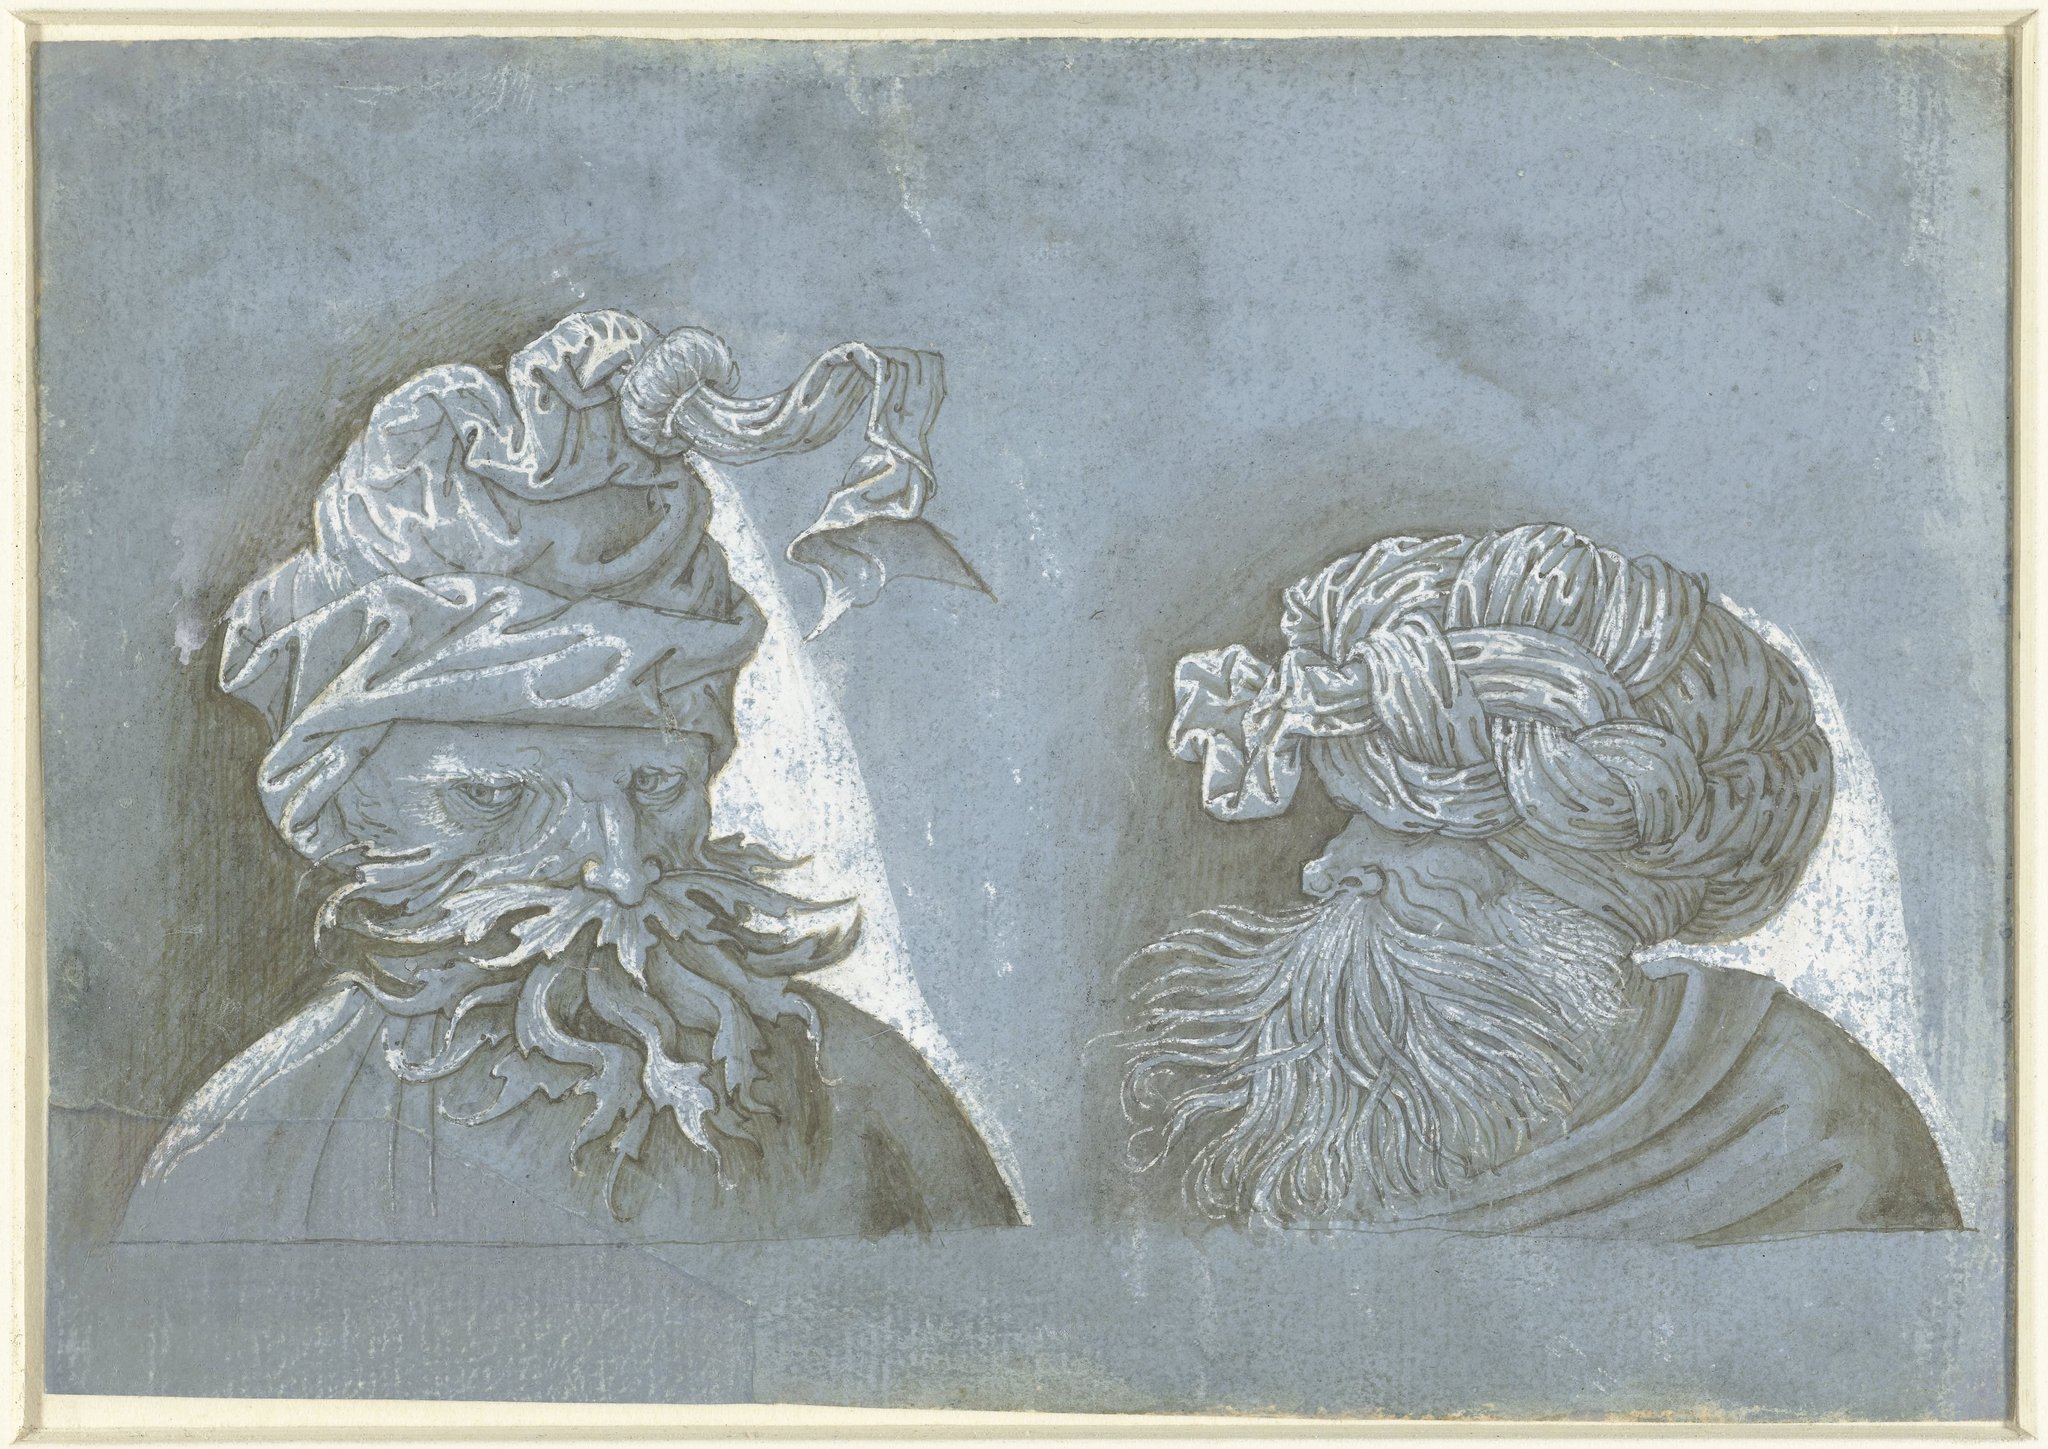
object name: drawing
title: Hoofden van mannen met hoofddeksels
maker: jacopo ripanda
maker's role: draughtsman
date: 1500-1525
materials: ink, paper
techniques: brush, pen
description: Blad uit serie met hoofden van mannen met uitheemse hoofddeksels op blauw en paars geprepareerd papier.